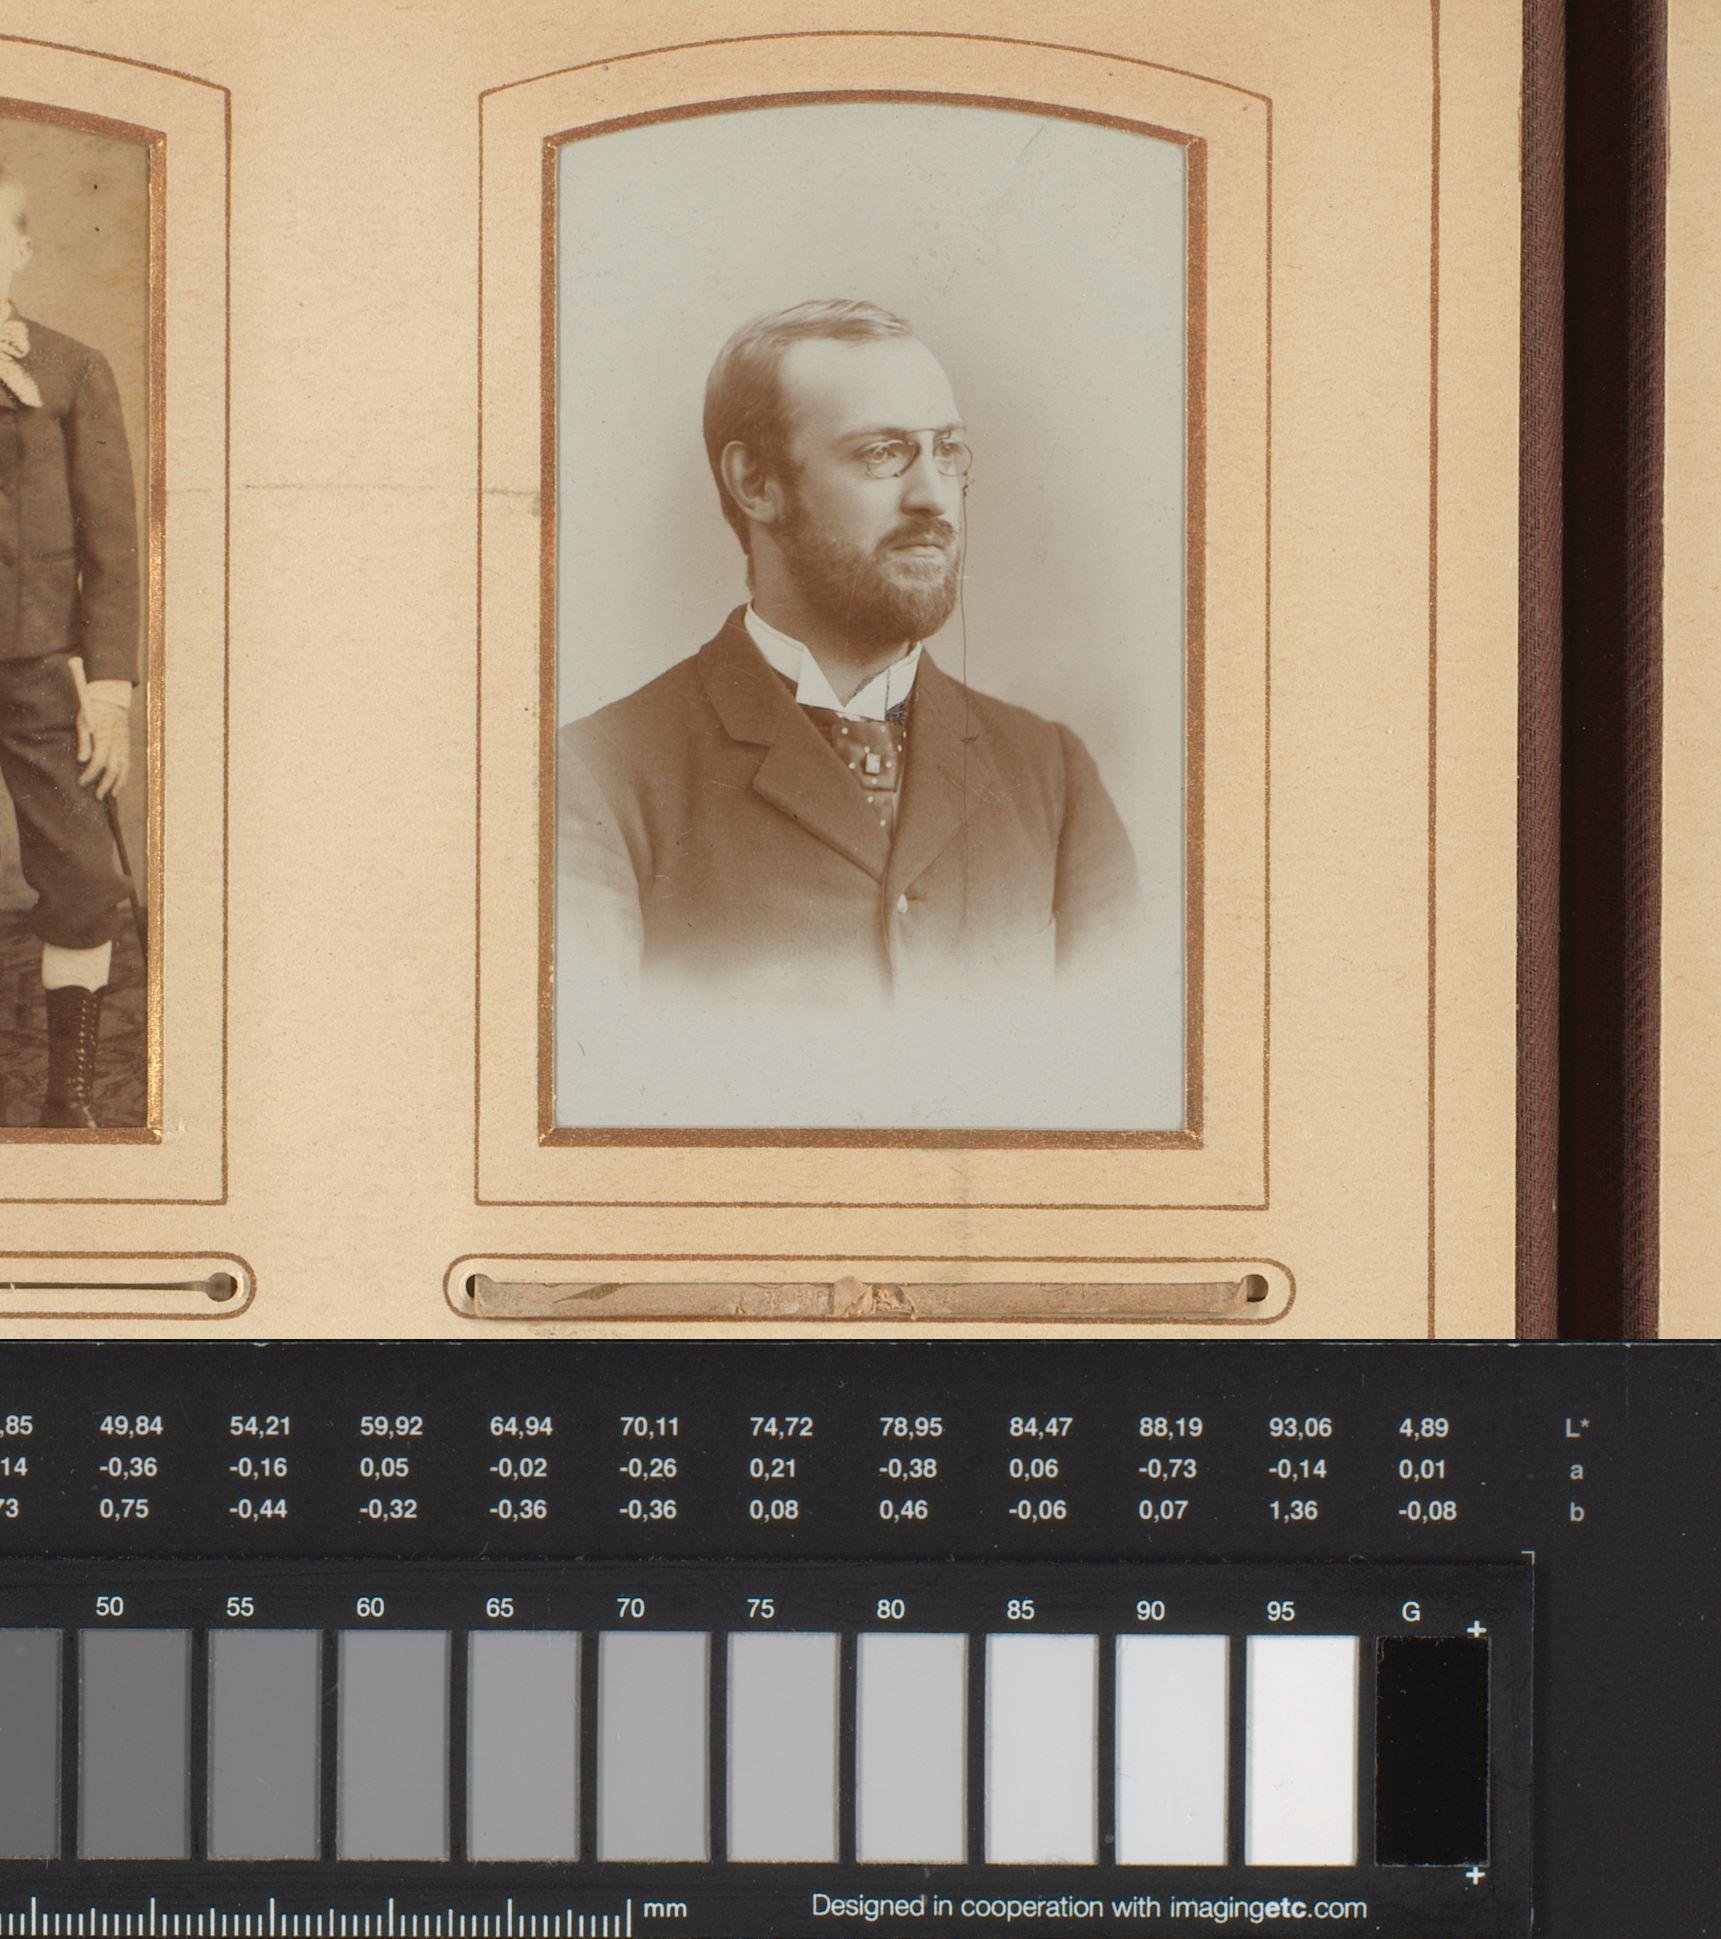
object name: album leaf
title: Portret van een man met baard en bril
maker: adolphe zimmermans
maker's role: fotograaf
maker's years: 1858-1922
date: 1890-1920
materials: cardboard, photographic support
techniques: collodion silver print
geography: the hague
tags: eyeglasses, spectacles, historical persons, beard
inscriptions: inscription: ‘De Riemerstraat 21’